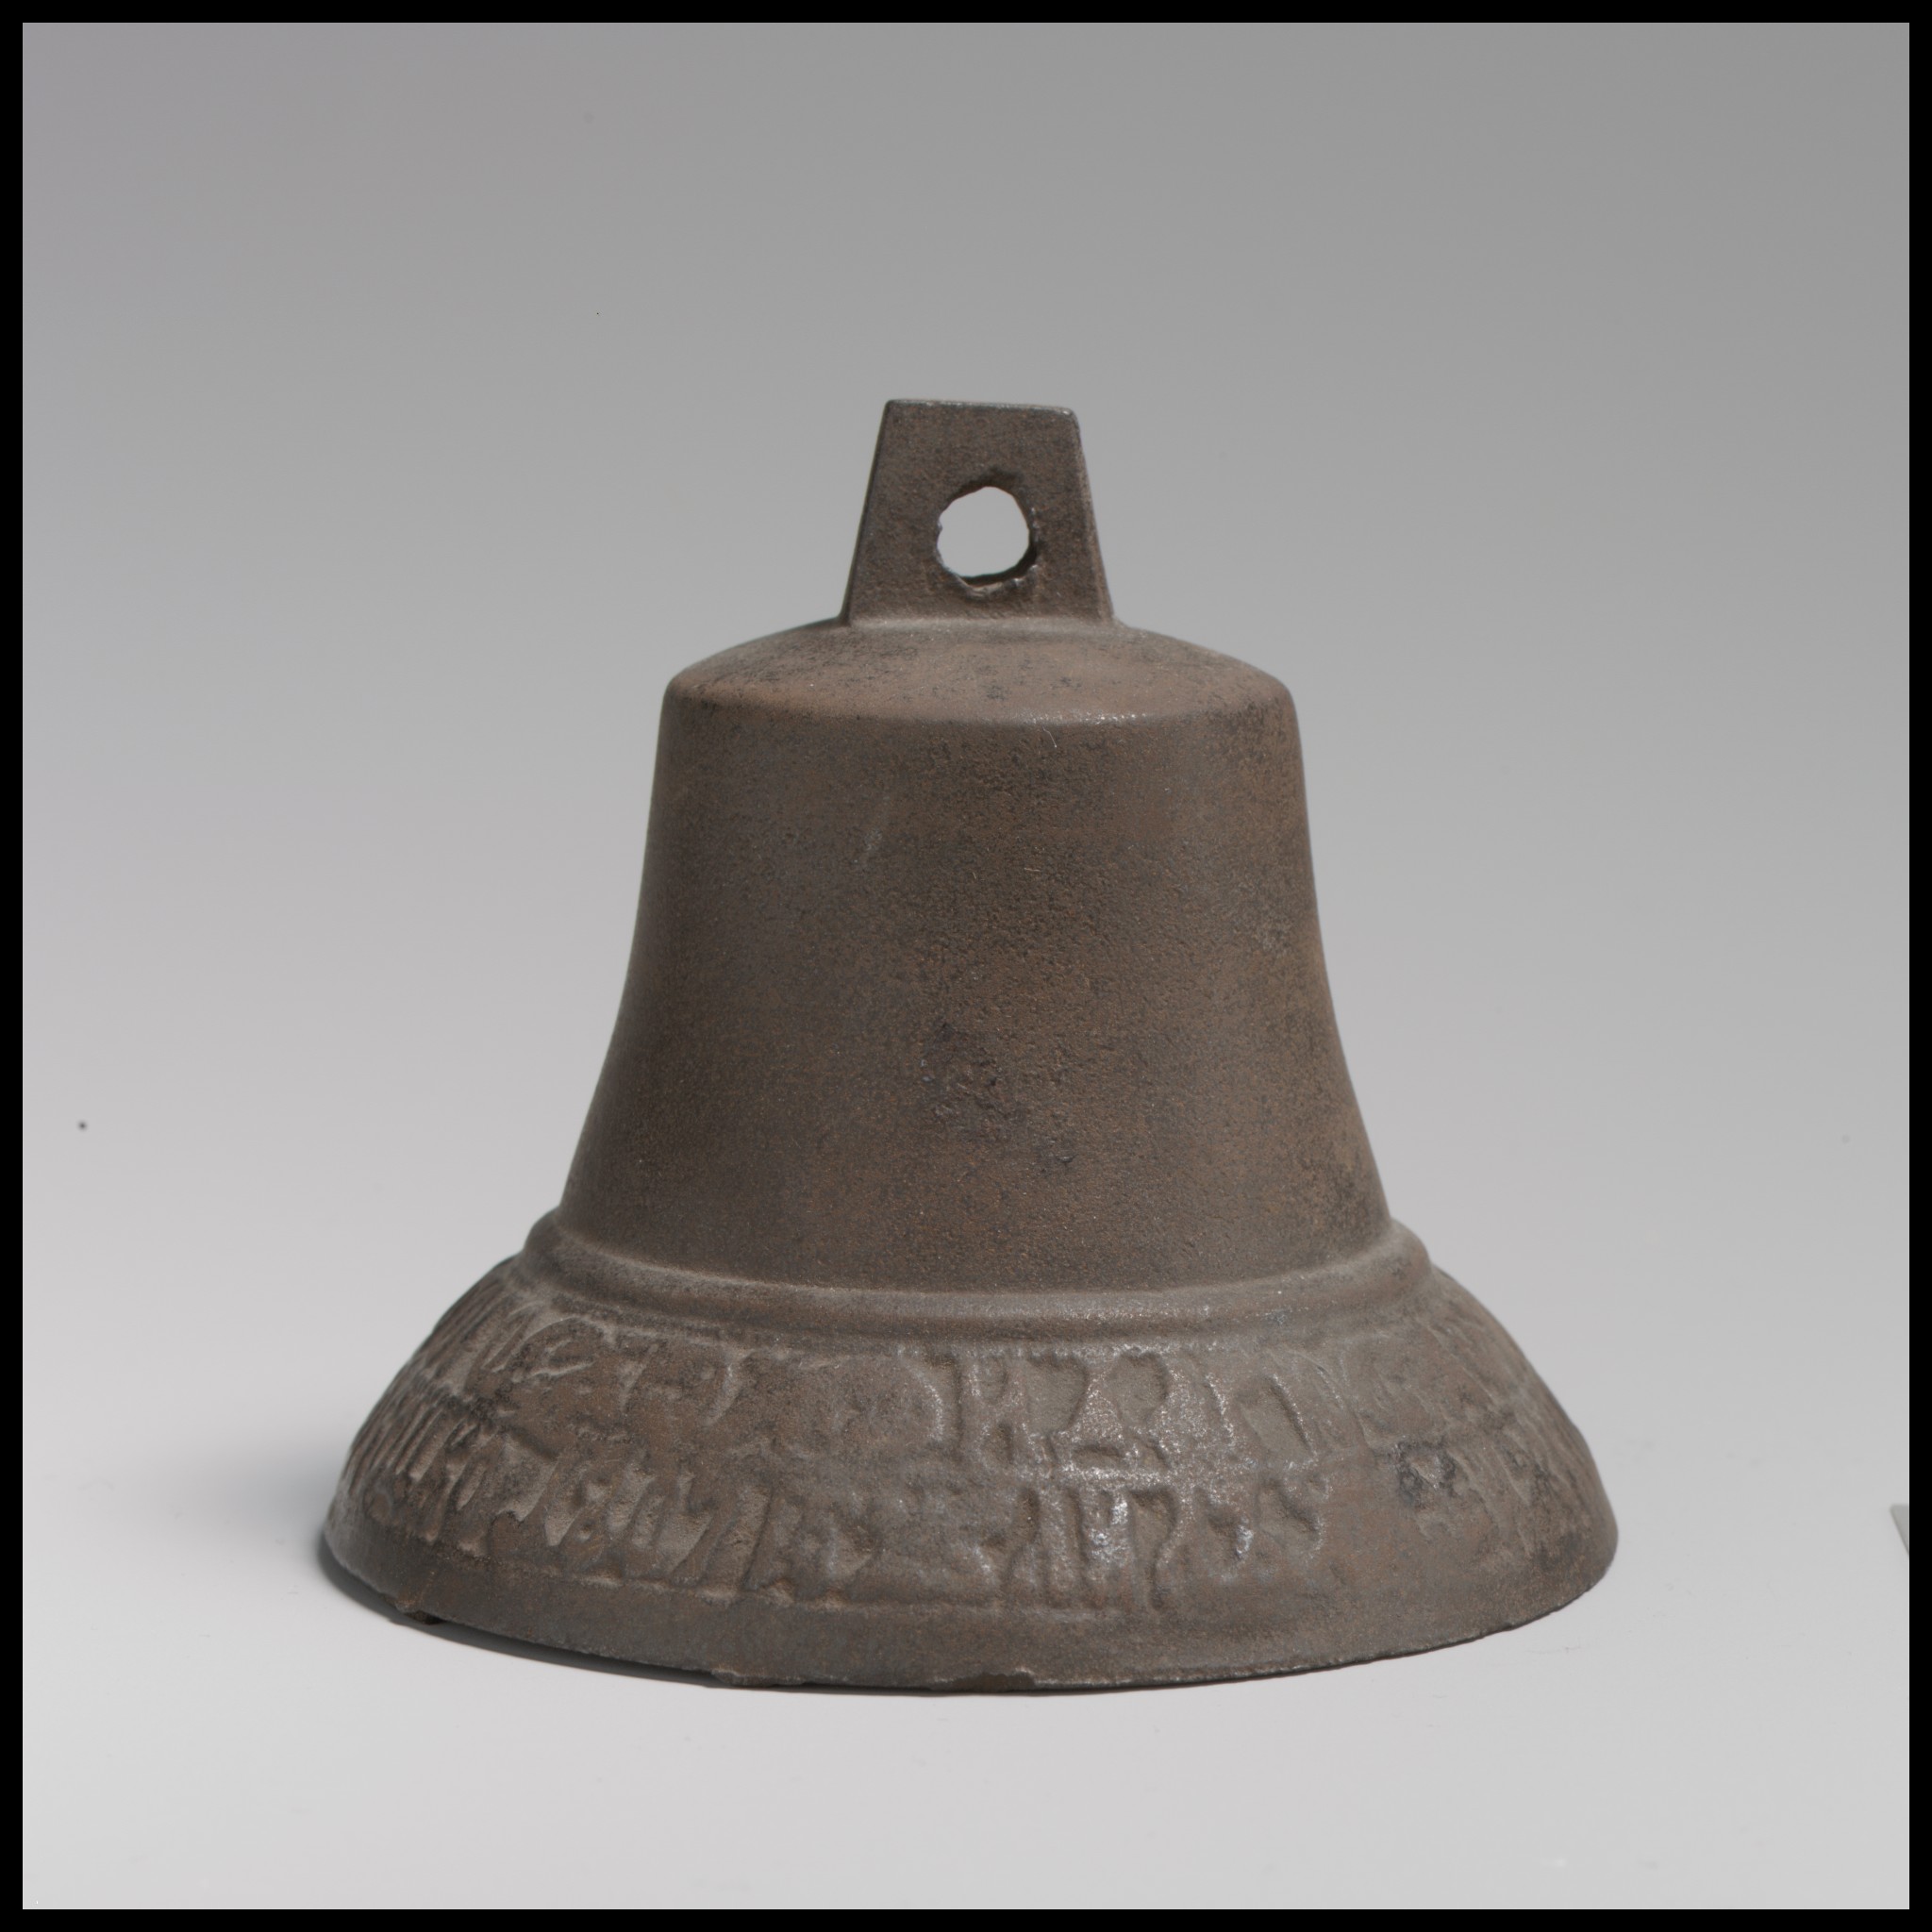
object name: bell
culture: russian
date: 1807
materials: iron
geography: russia